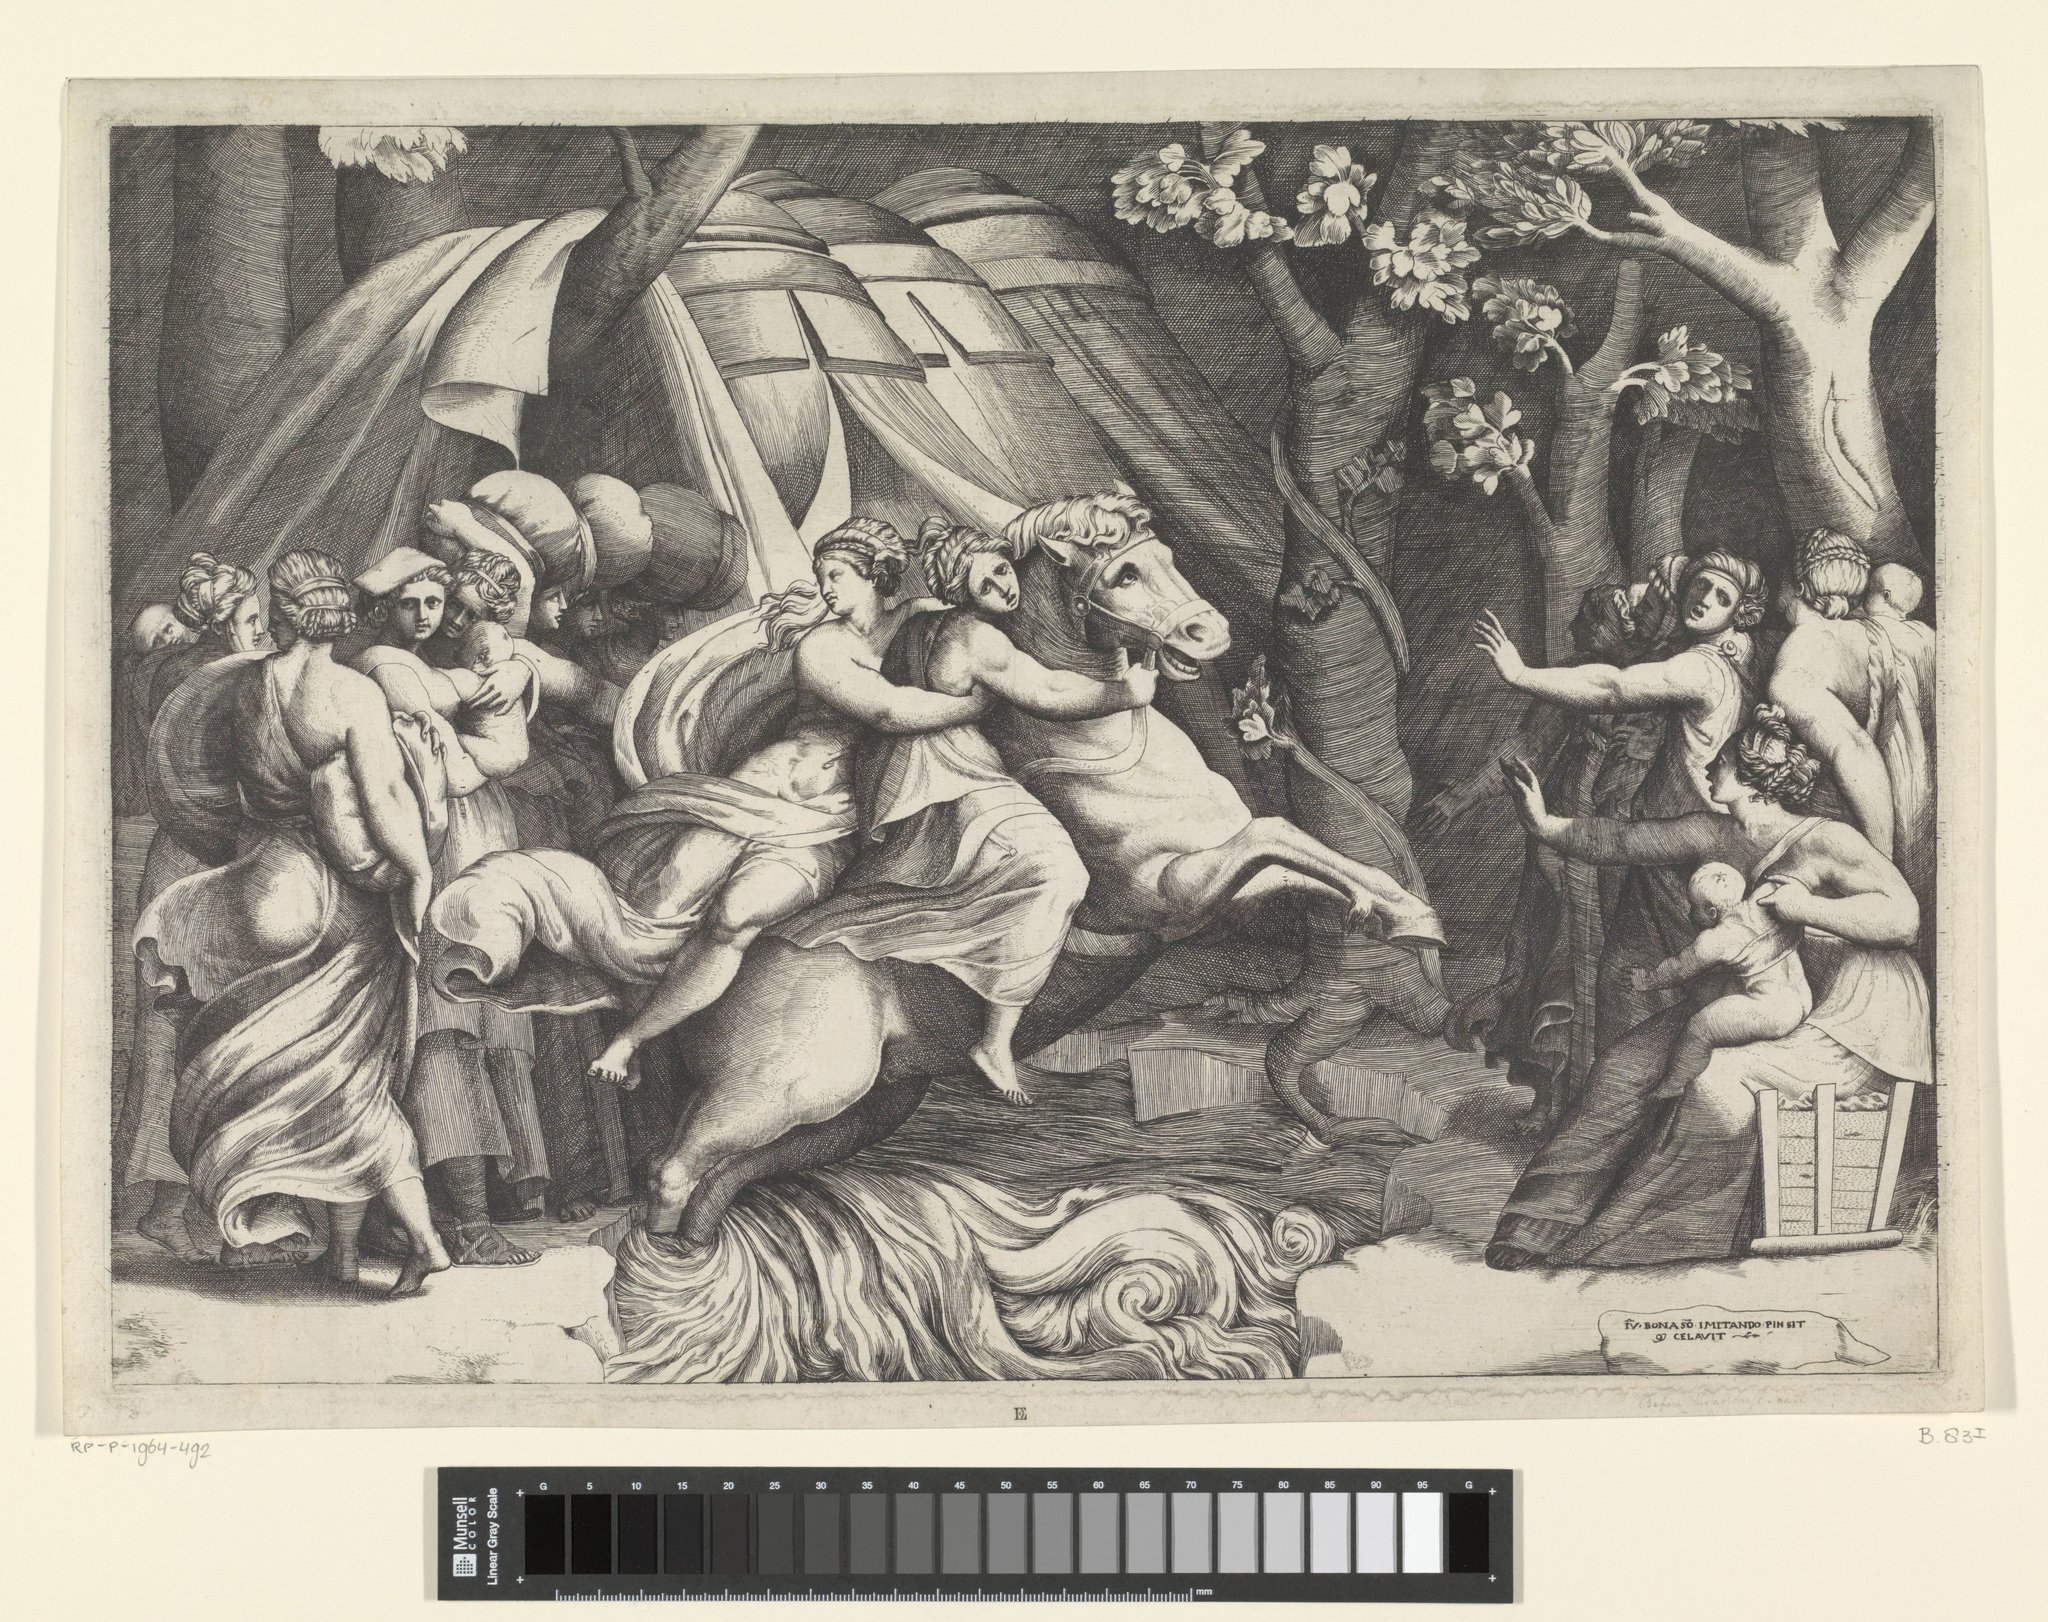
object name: print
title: Cloelia steekt de Tiber over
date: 1501-1580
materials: paper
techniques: engraving, etching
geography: italy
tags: cloelia and her companions escape porsena's camp: she crosses the tiber on horseback and persuades her companions to swim after her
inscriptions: collector's mark: Lugt 741, collector's mark: Lugt 2228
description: De uit gevangenschap ontsnapte Cloelia vlucht naar Rome. Ze steekt te paard de rivier de Tiber over. Links op de oever staat een groep vrouwen met kinderen voor tenten. Rechts staan vrouwen op de oever die Cloelia proberen tegen te houden.